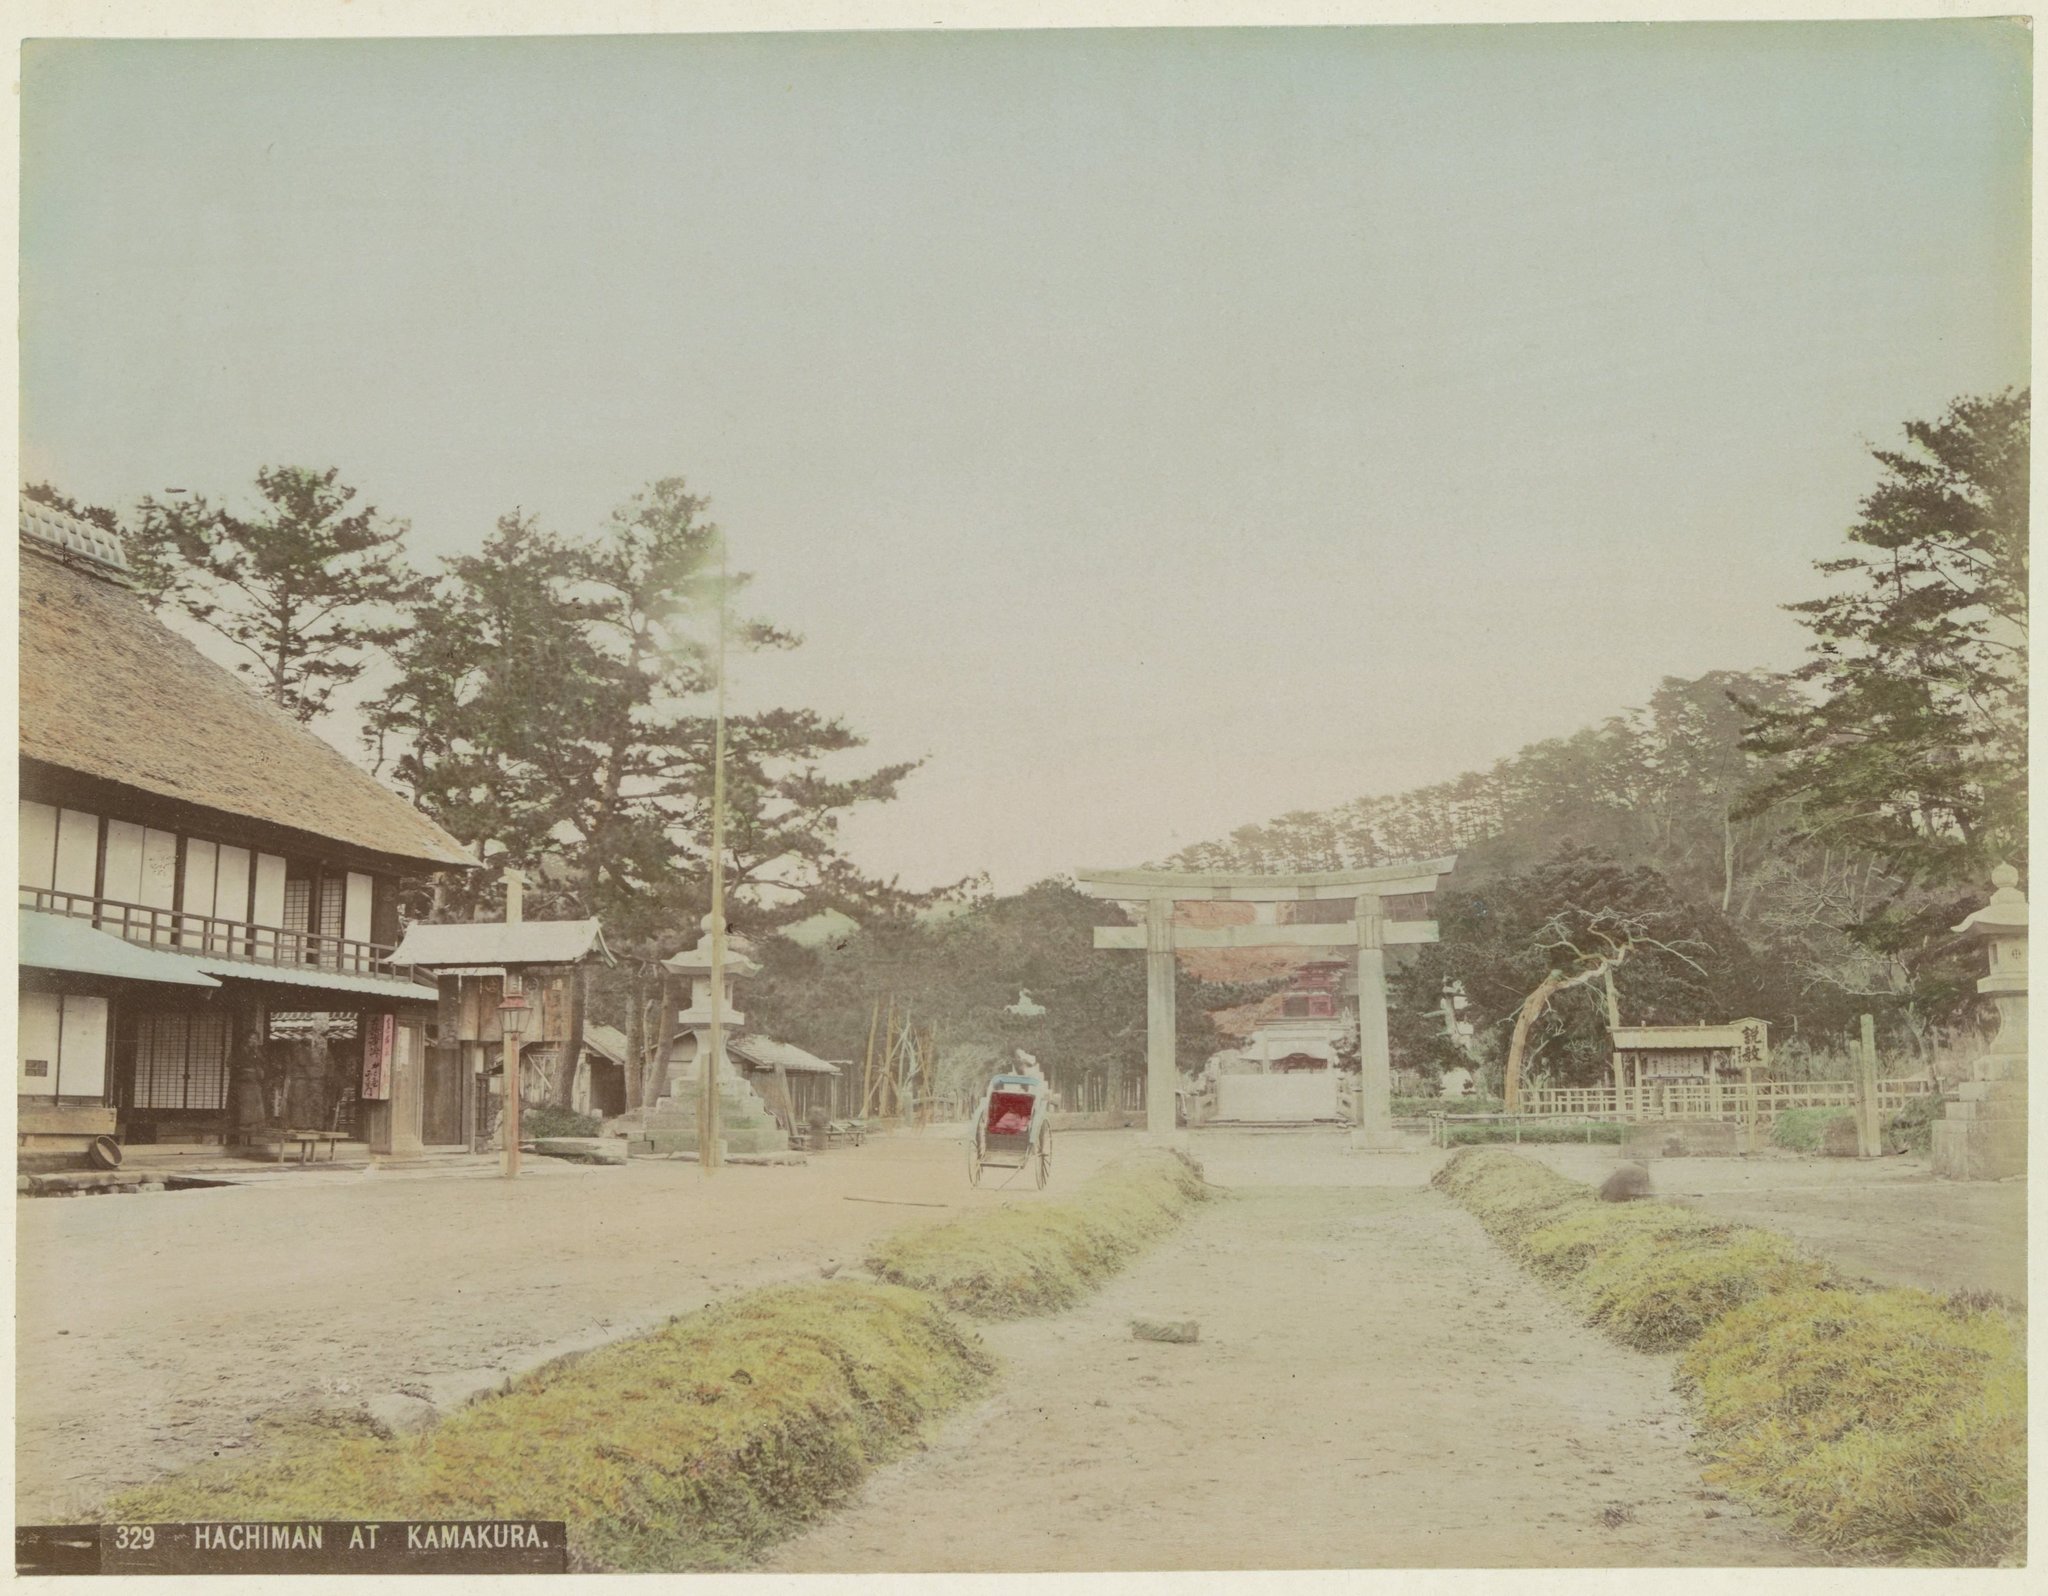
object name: photograph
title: Ingang van een tempel gewijd aan Hachiman in Kamakura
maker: Anonymous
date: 1870-1900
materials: cardboard, paper, photographic support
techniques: albumen print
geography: kamakura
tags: temple, shrine ~ hinduism, buddhism, jainism, gate, entrance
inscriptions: negative number: ‘329’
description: Onderdeel van Reisalbum met foto's van bezienswaardigheden in Japan.